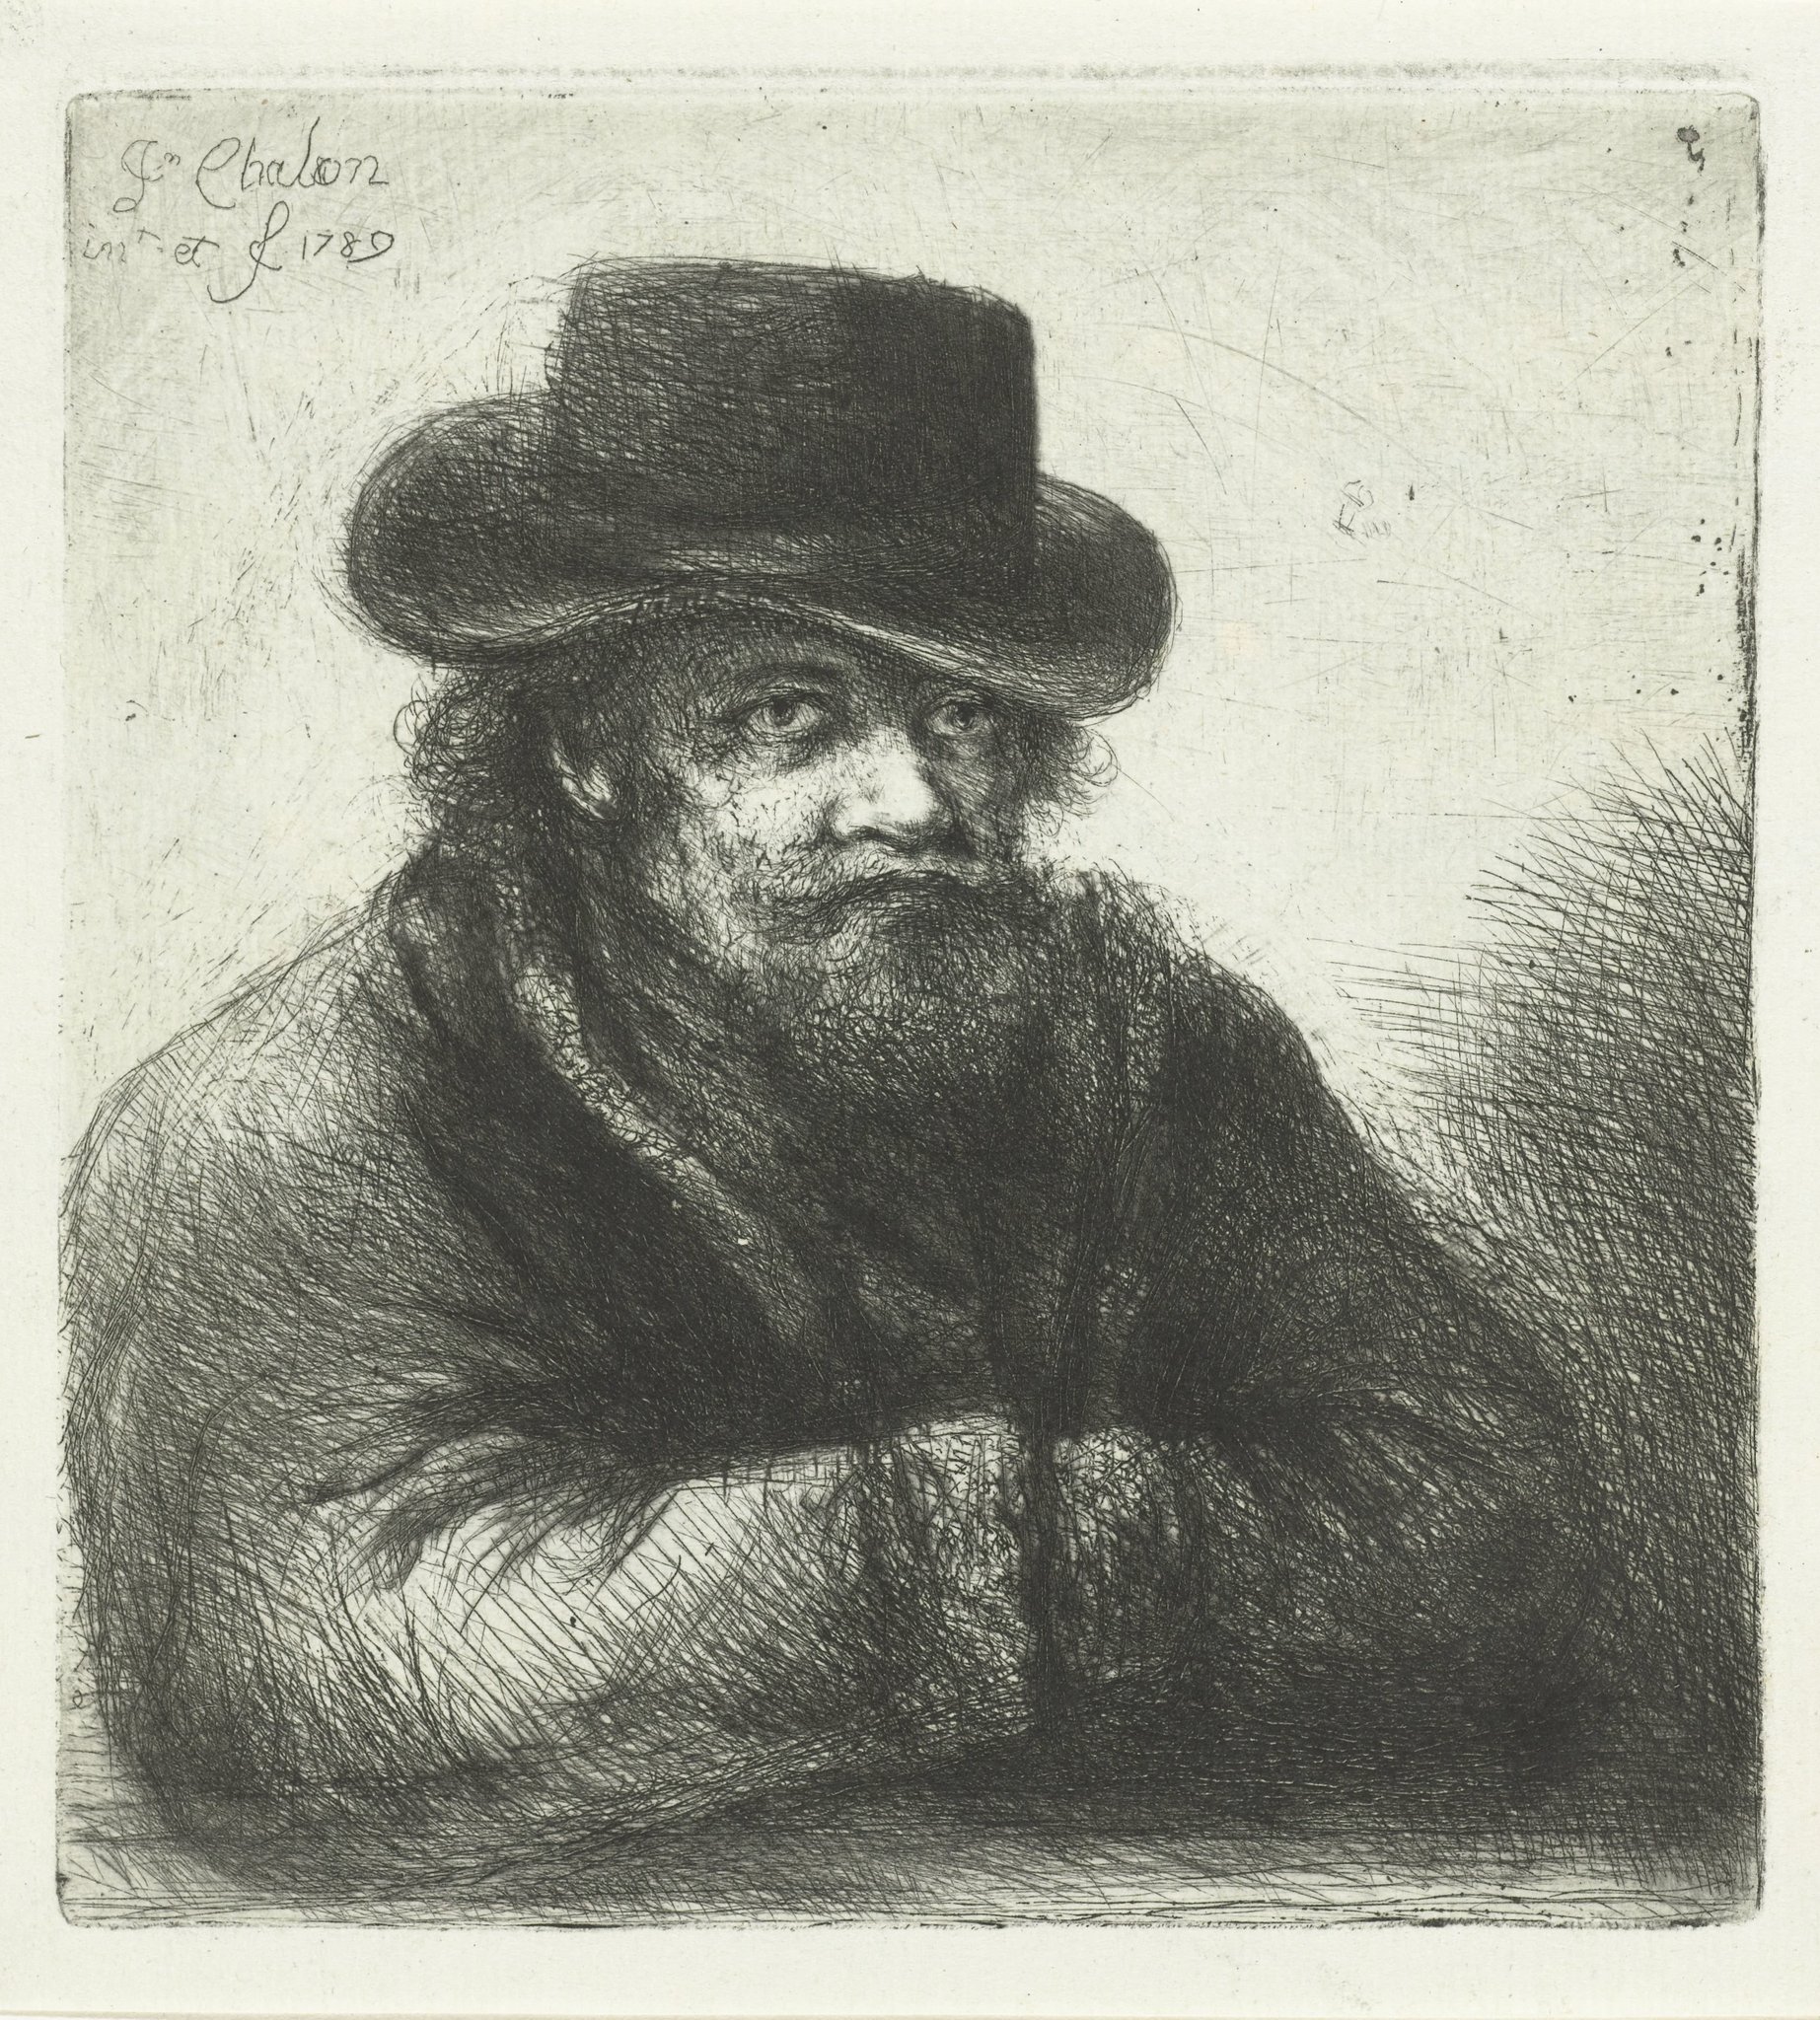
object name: print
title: Oude man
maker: jan chalon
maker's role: print maker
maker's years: 1738-1795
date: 1789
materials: paper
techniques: drypoint, etching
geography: northern netherlands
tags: head-gear: hat (+ men's clothes), morphology of human expression (+ old male (human being))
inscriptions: collector's mark: Lugt 2228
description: Een oude man met baard en een hoed. Buste naar rechts.